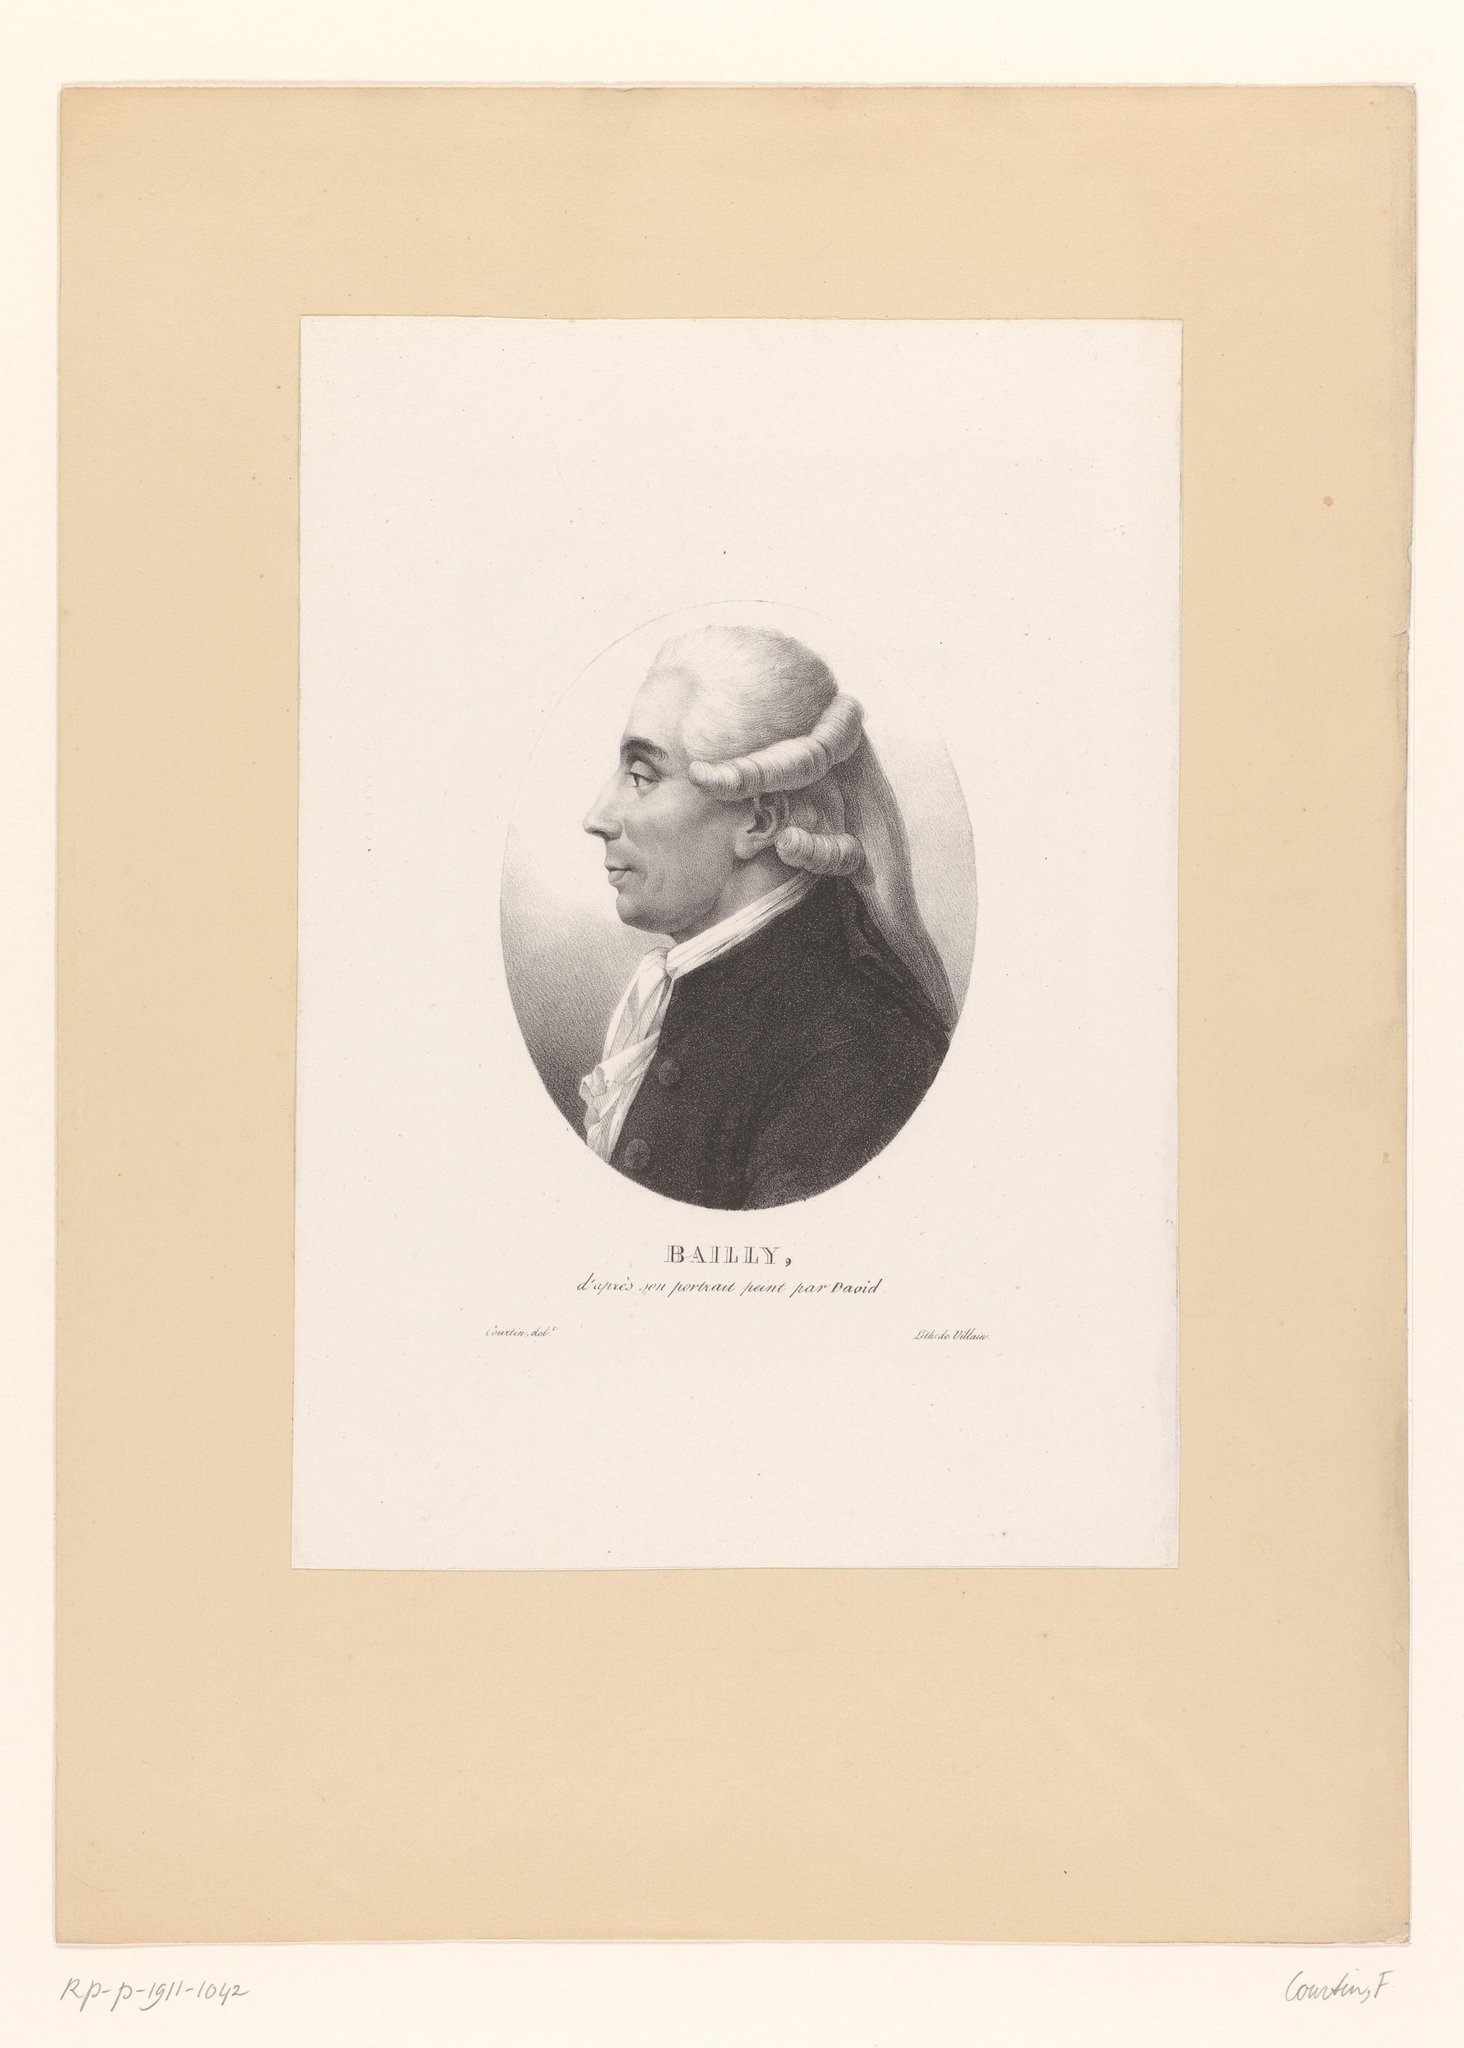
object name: print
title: Portret van Jean Sylvain Bailly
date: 1828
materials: paper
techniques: lithograph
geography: paris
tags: paris, politician, mayor, historical persons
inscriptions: collector's mark: Lugt 2228a